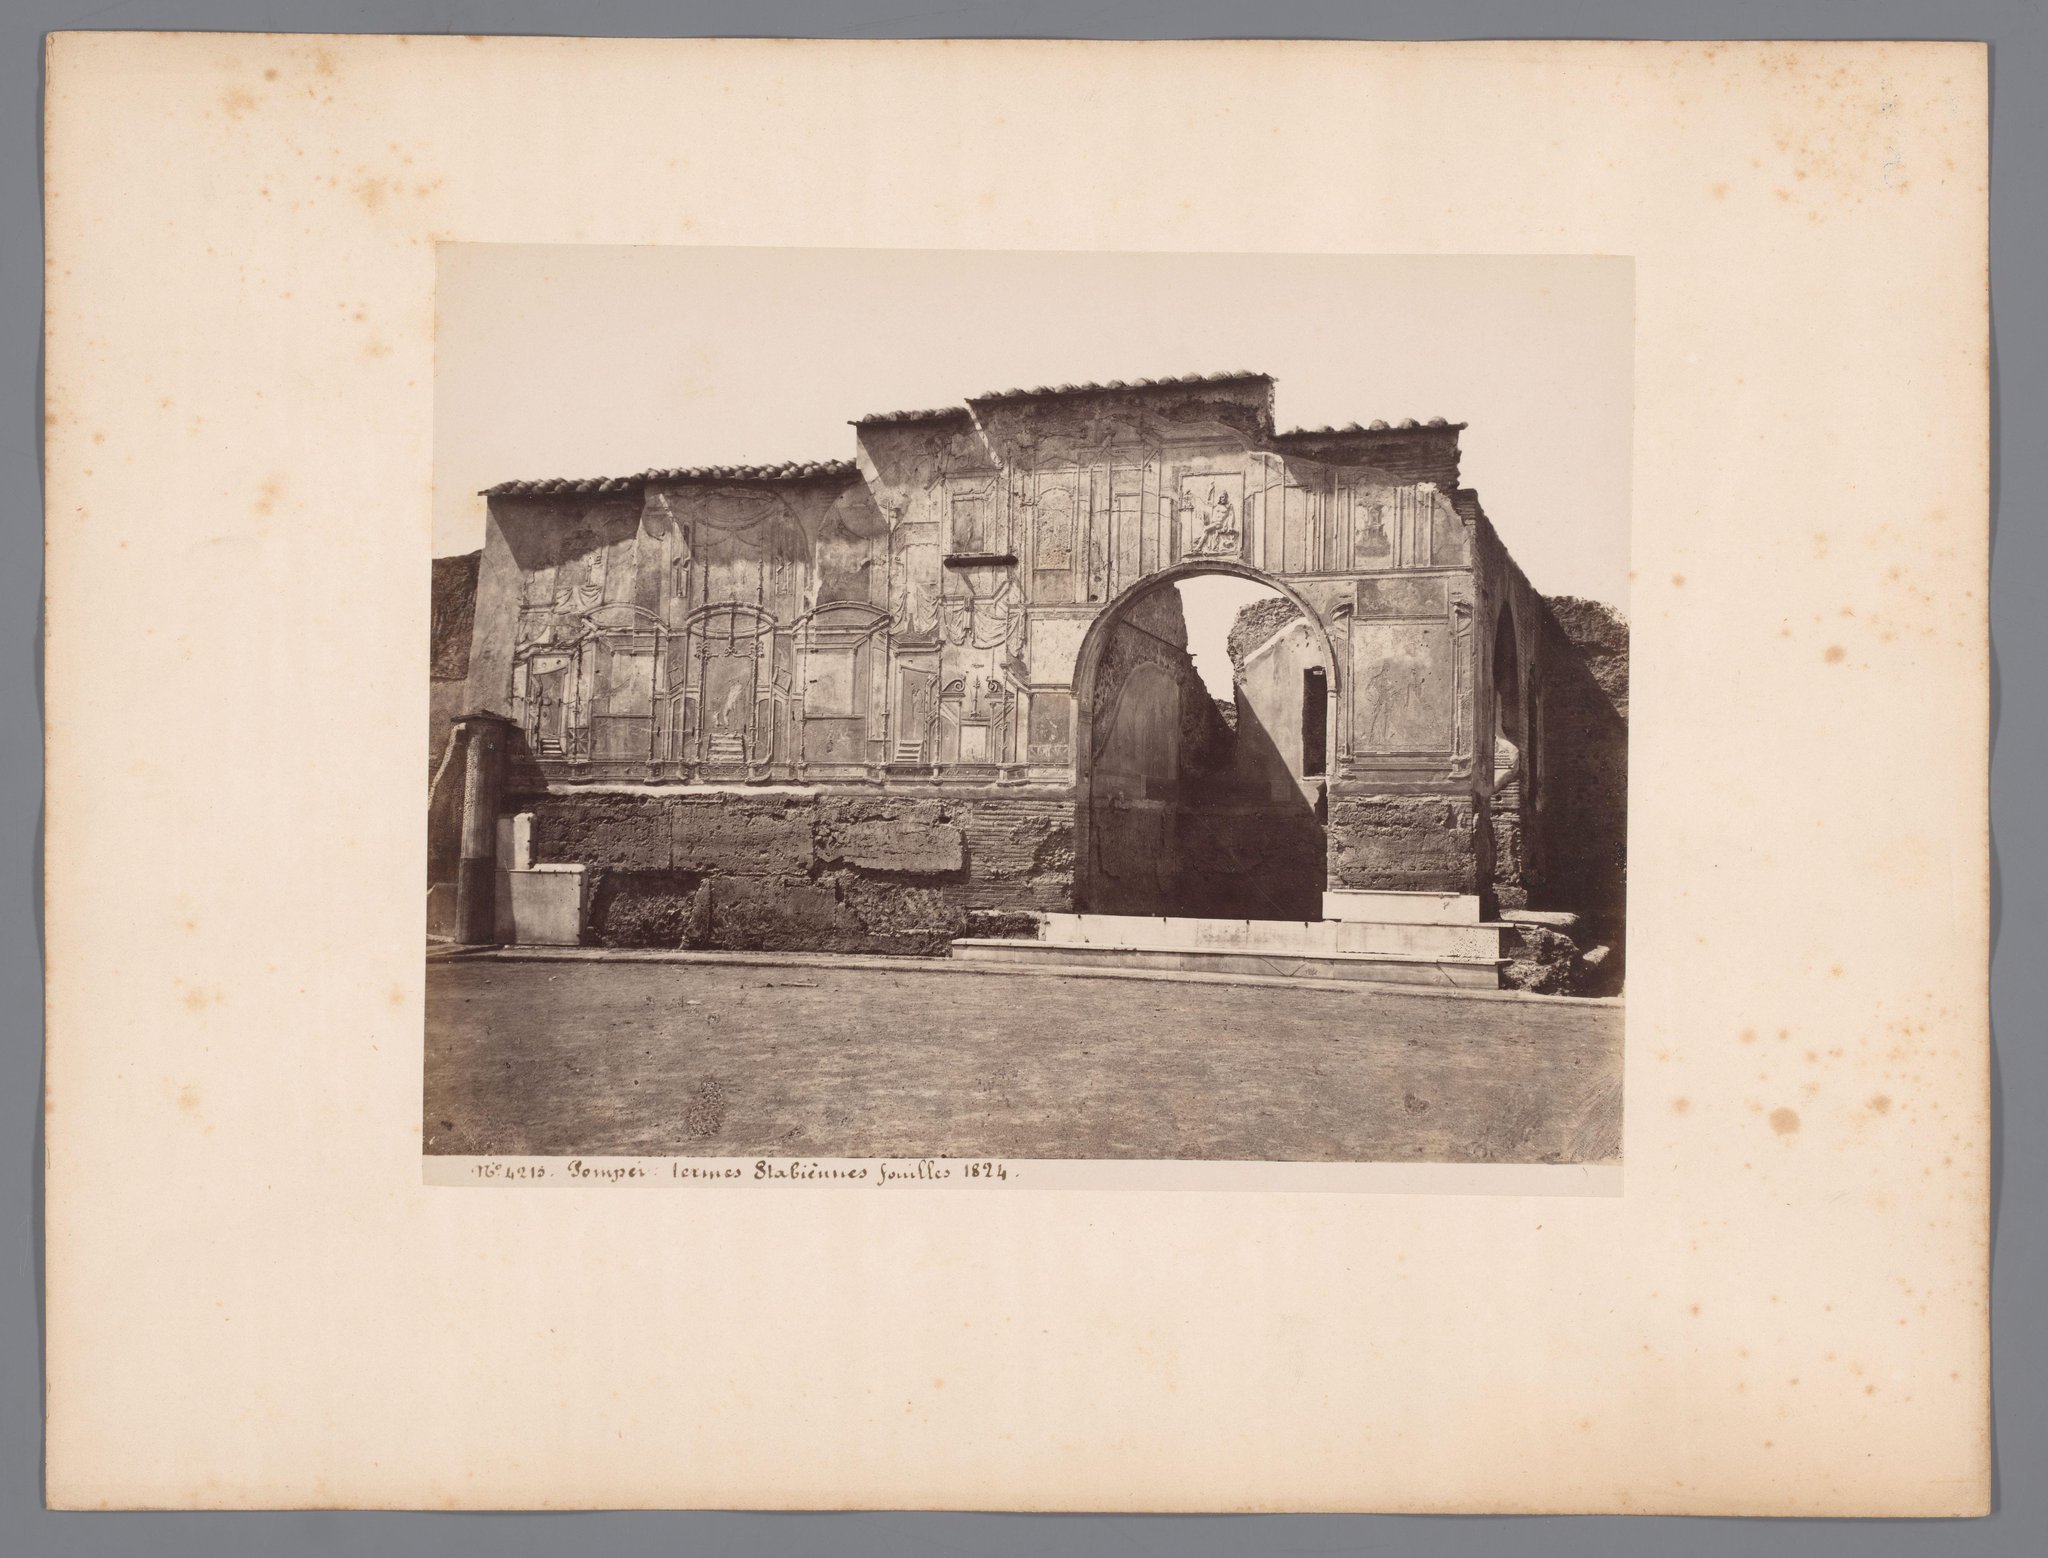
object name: photograph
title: Pompei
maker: giorgio sommer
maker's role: fotograaf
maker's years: 1834-1914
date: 1857-1875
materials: cardboard, paper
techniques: albumen print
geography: pompeii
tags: ruin of a building ~ architecture, excavation ~ archaeology, pompeii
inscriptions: number: ‘11’, number: ‘21’, number: ‘No. 4215’, number: ‘57’